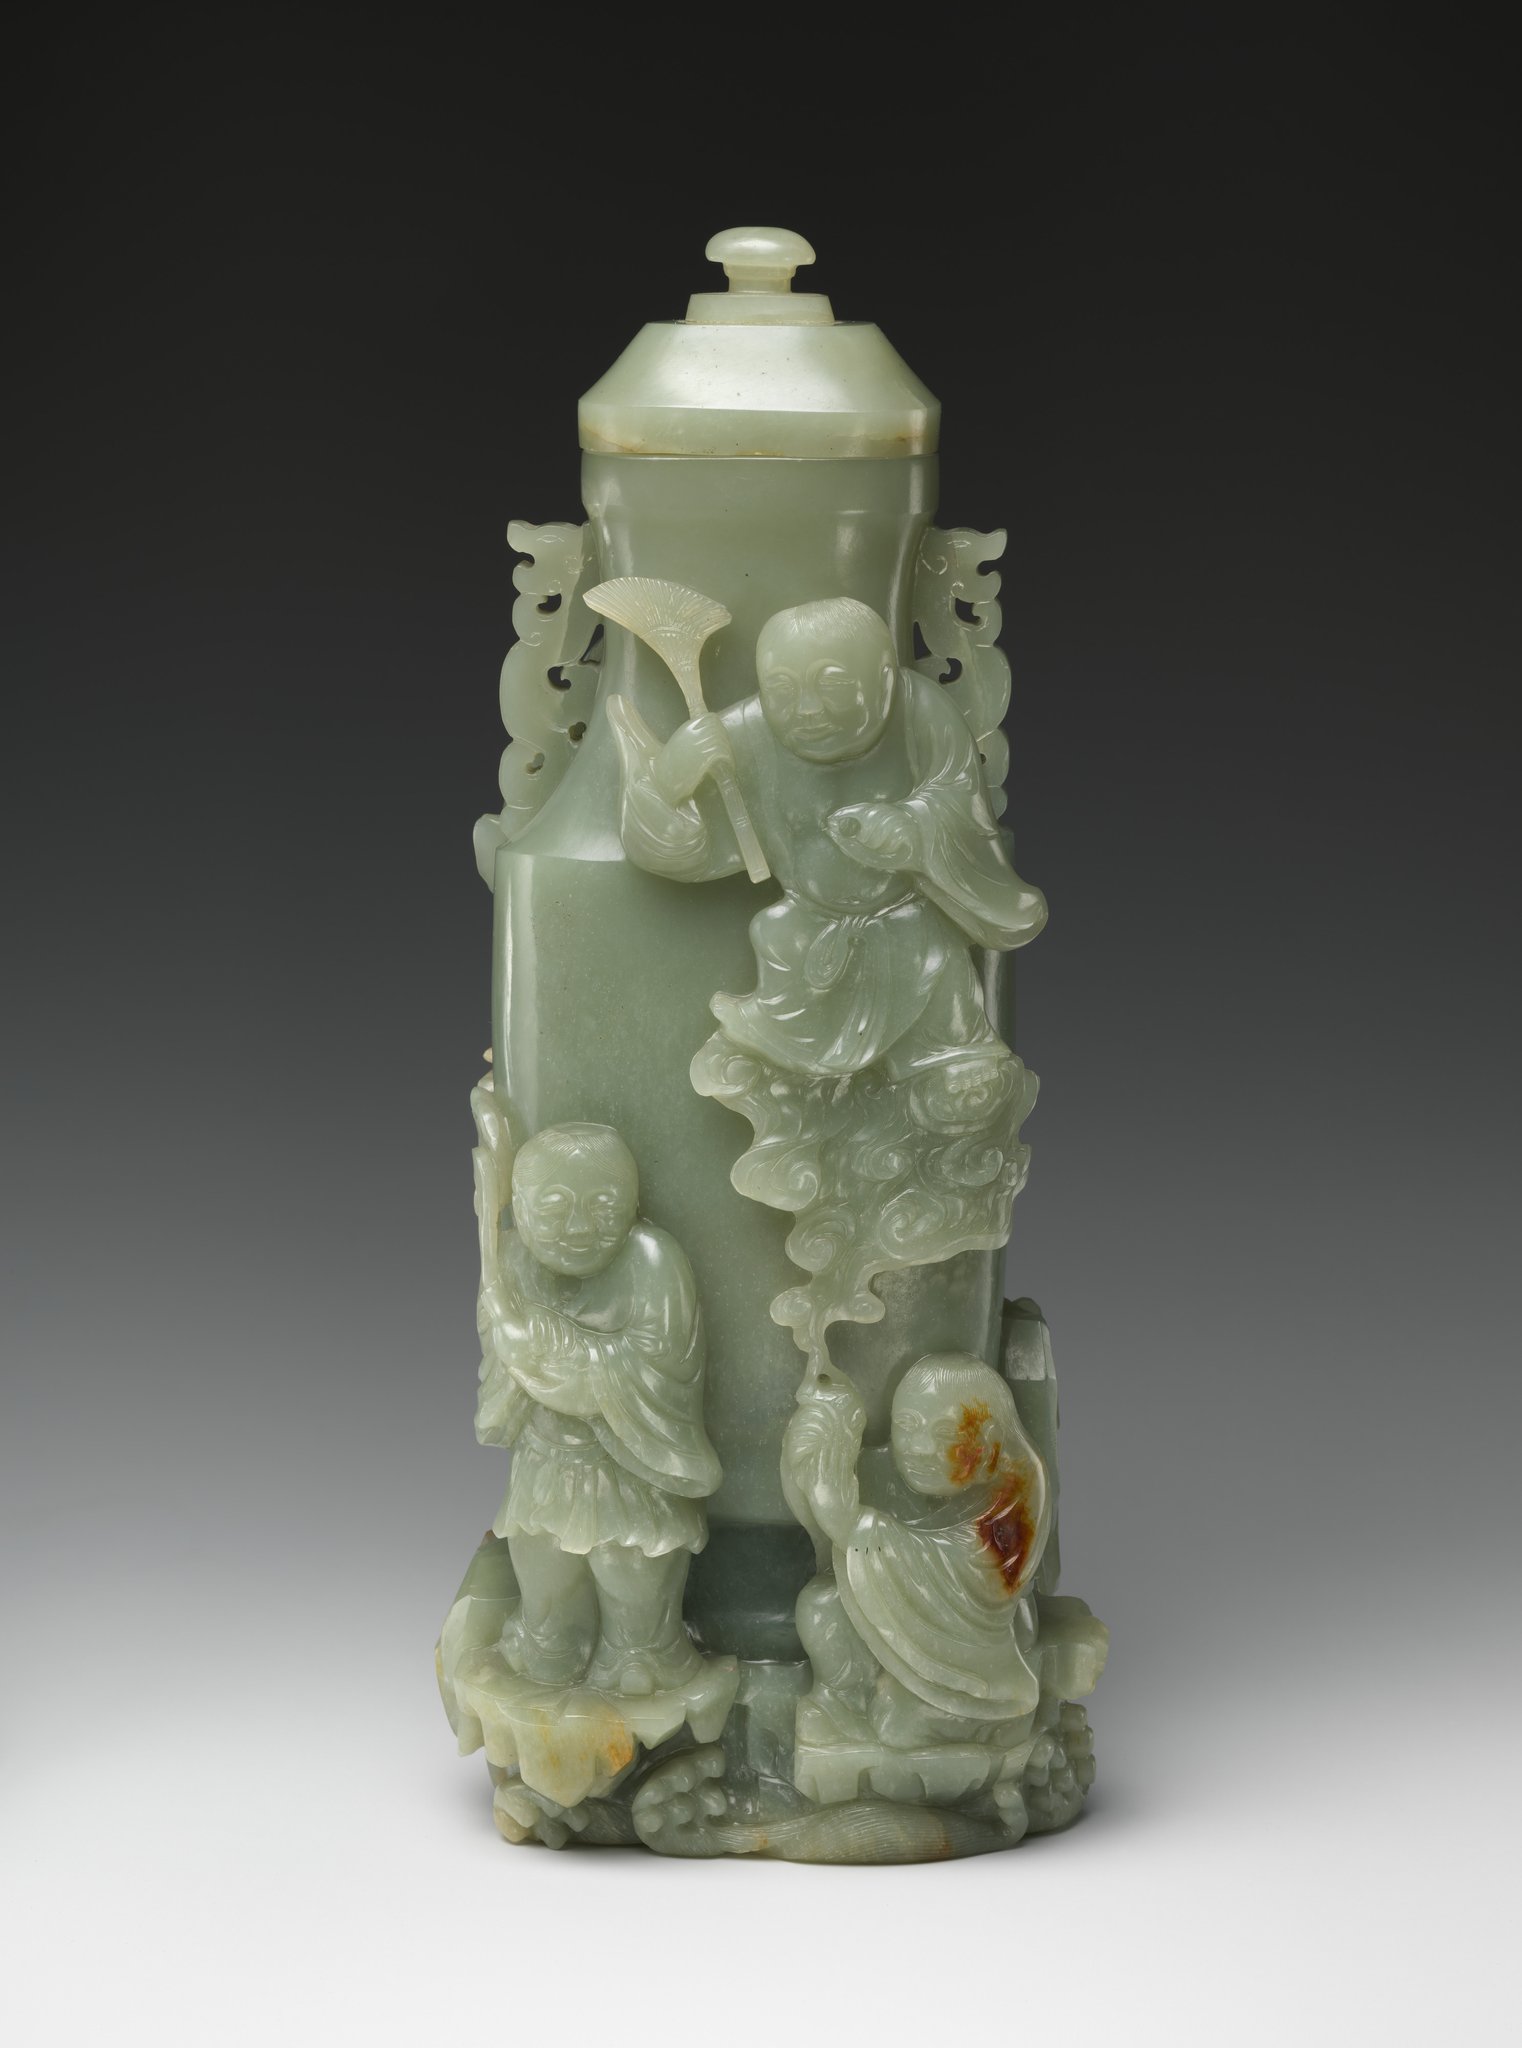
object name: covered vase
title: Covered vase with immortals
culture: chinese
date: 1701-1900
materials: jade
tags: men